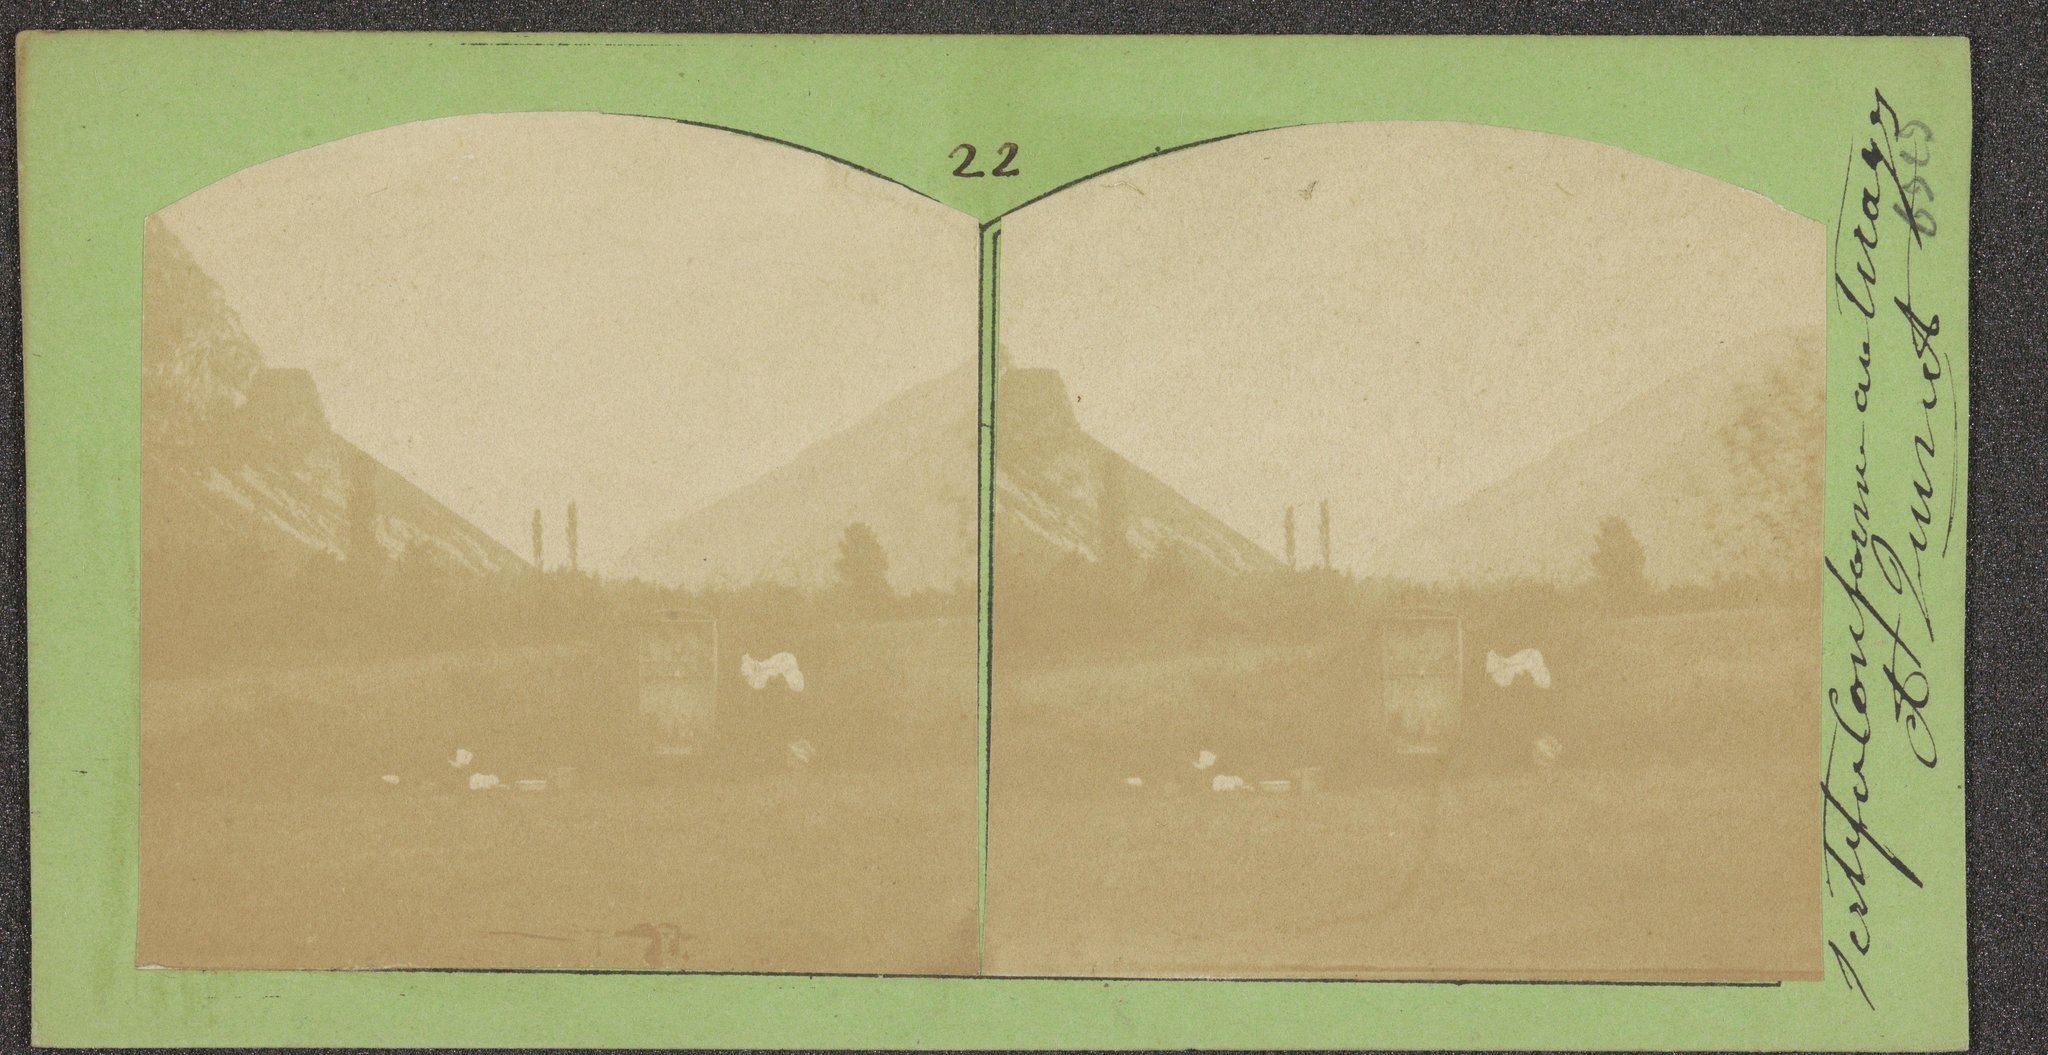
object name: stereograph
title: Voet van de Alpen met een staand voorwerp op de voorgrond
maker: achille quinet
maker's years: 1831-1900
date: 1860-1880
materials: cardboard, paper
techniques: albumen print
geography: alps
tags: mountains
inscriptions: signature: ‘Sertifier conforme au tirages // A Quinet’